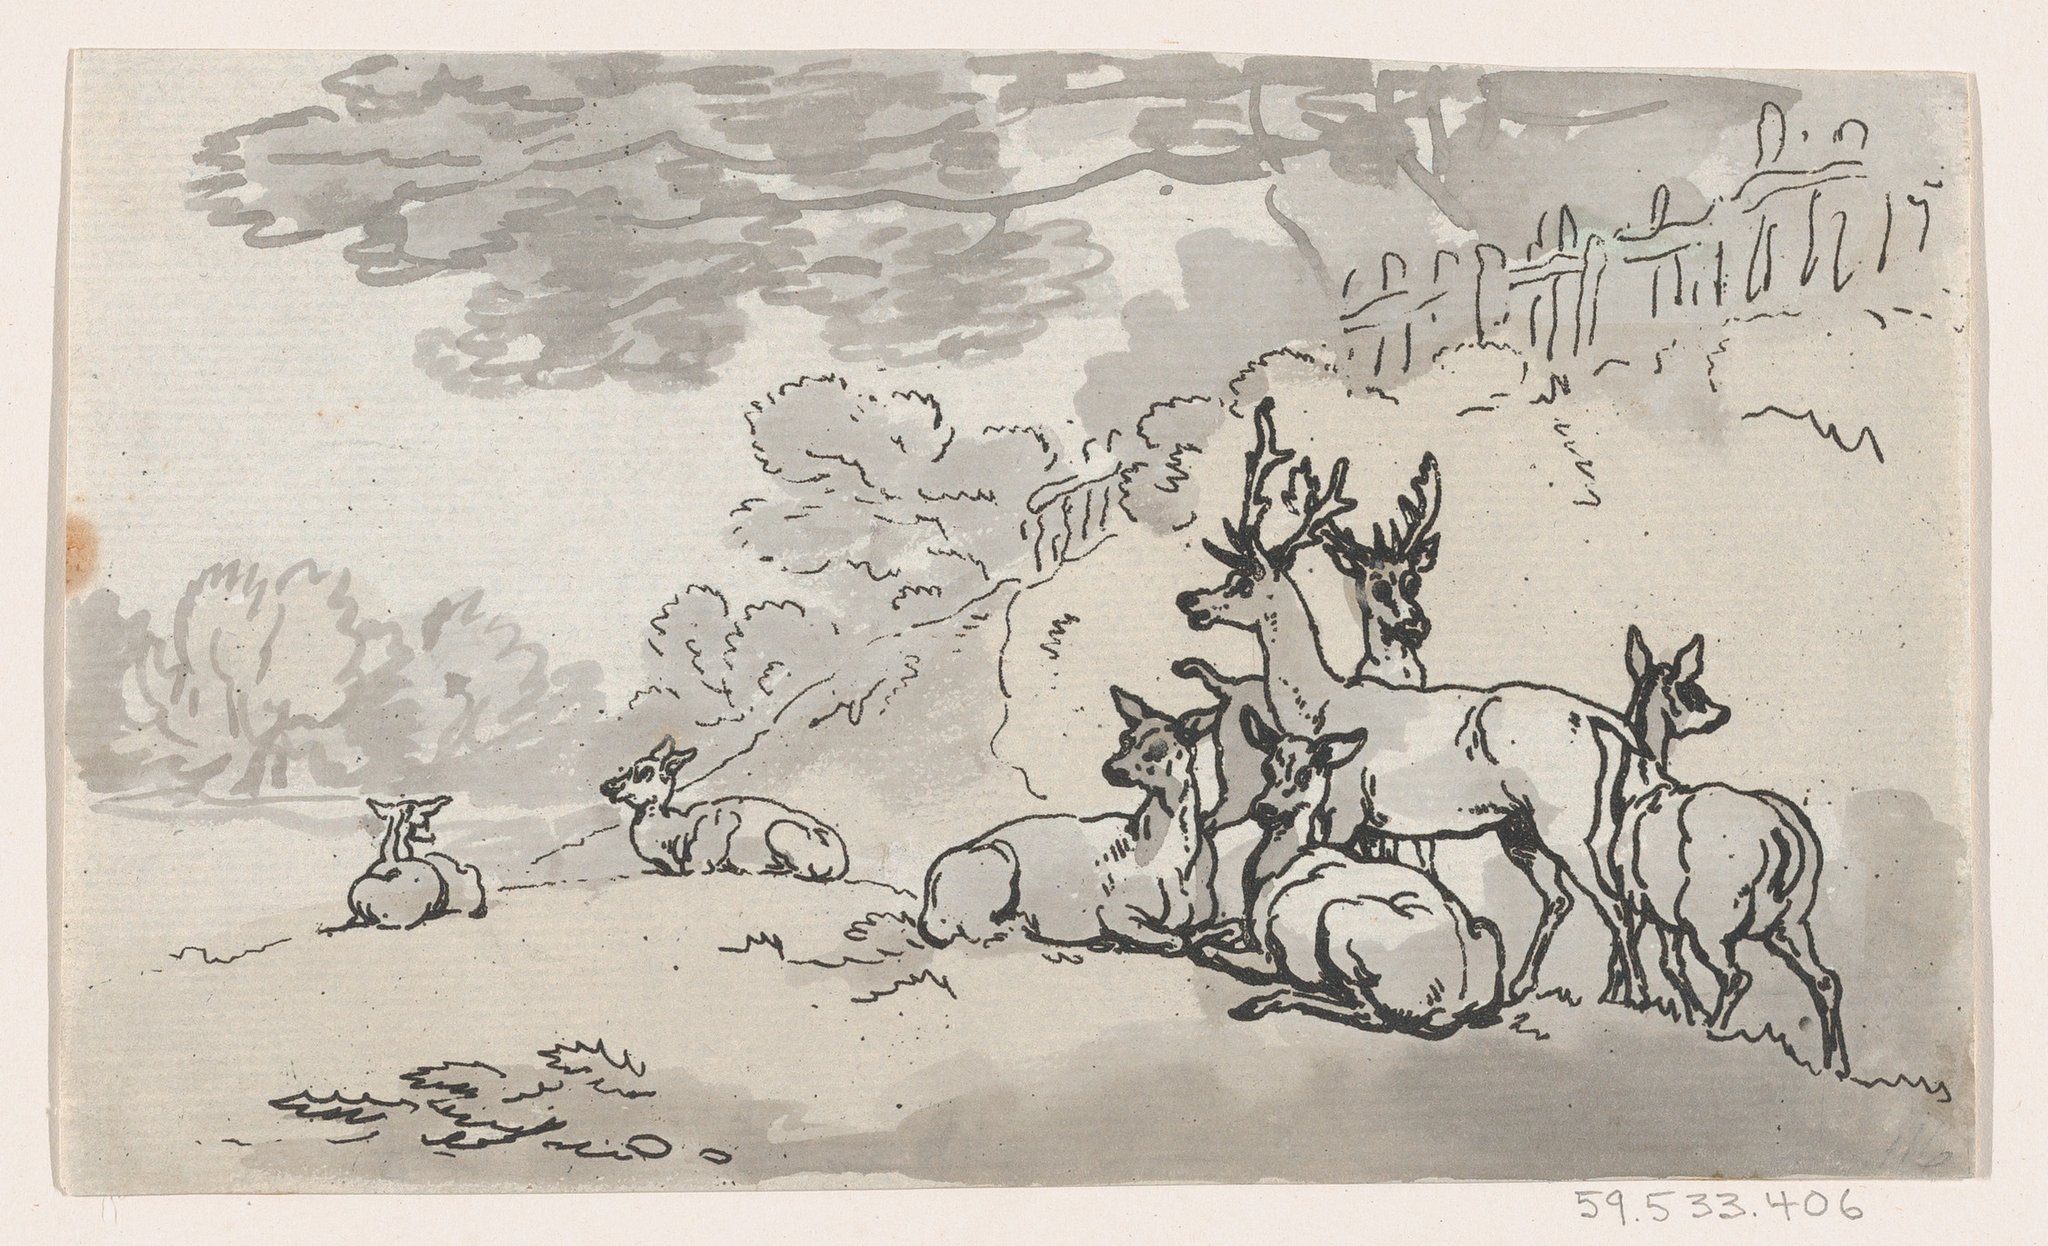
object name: print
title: Deer (from Plate 3, Outlines of Figures, Landscapes and Cattle...for the Use of Learners)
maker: thomas rowlandson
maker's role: artist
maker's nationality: british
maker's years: 1757-1827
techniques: etching, wash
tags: deer